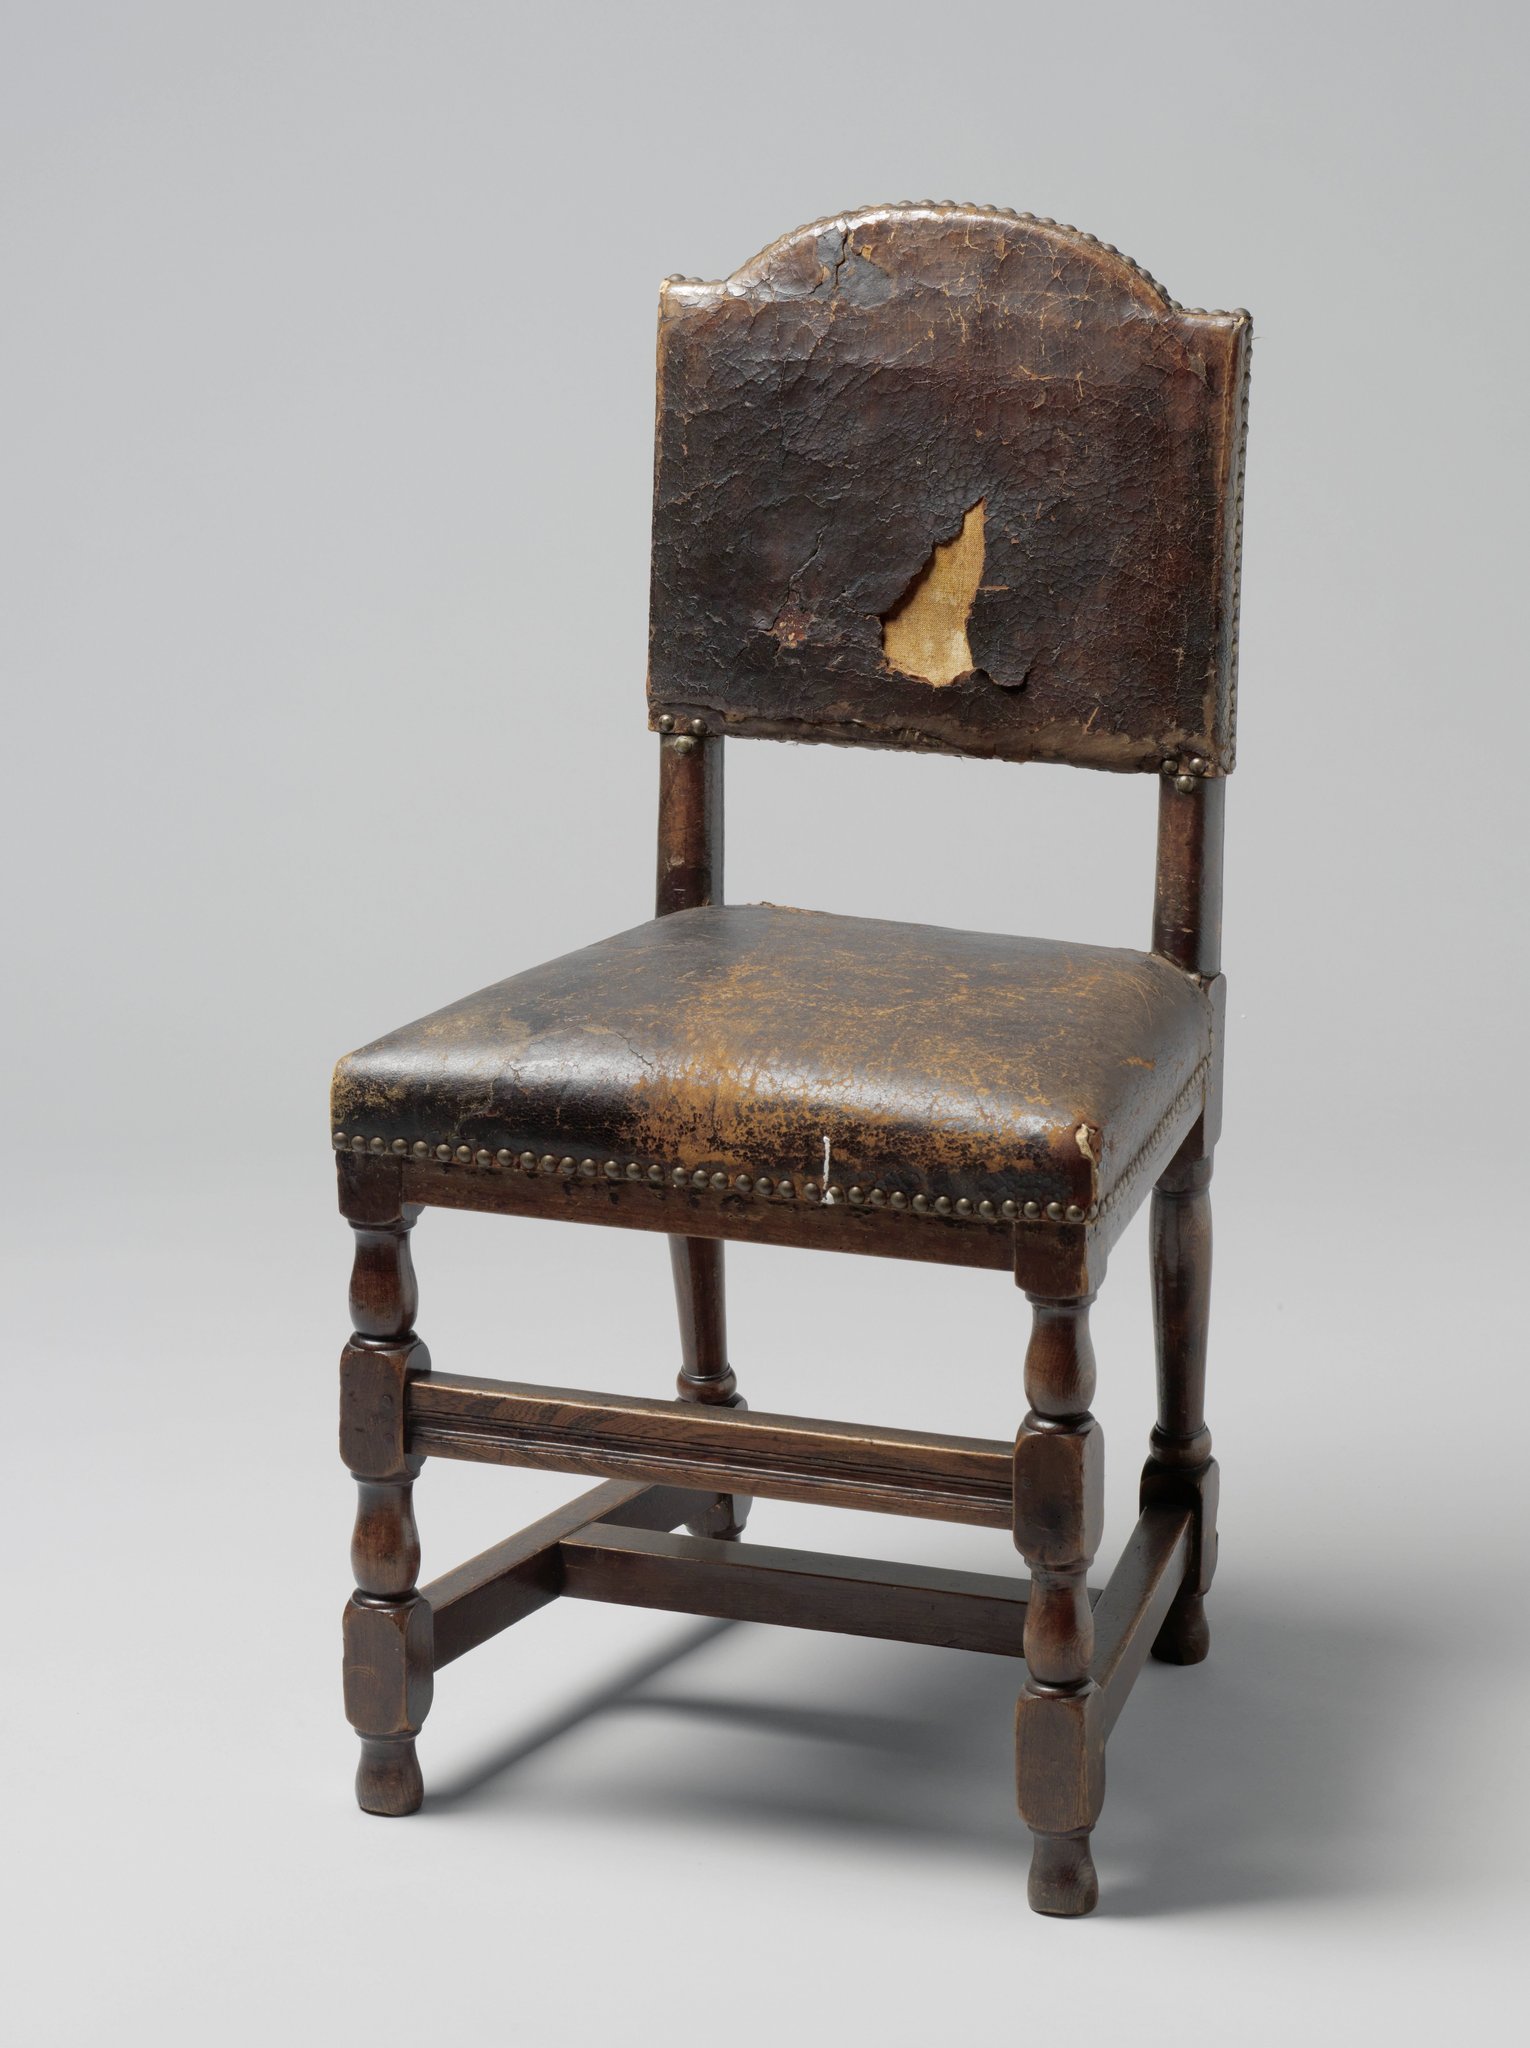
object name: chair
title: Stoel van eikenhout met zitting en rug van leer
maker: Anonymous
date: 1675-1700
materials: wood, leather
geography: northern netherlands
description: Acht eikenhouten stoelen met leren zitting en rug. De poten vertonen huis en geleden en zijn verbonden door een H-vormig kruis. Aan de voorzijde bevindt zich, tussen twee huizen, een brede voorsport. De achterpoten wijken naar achteren. De rug rust hoog op de stutten en is van boven gebogen.